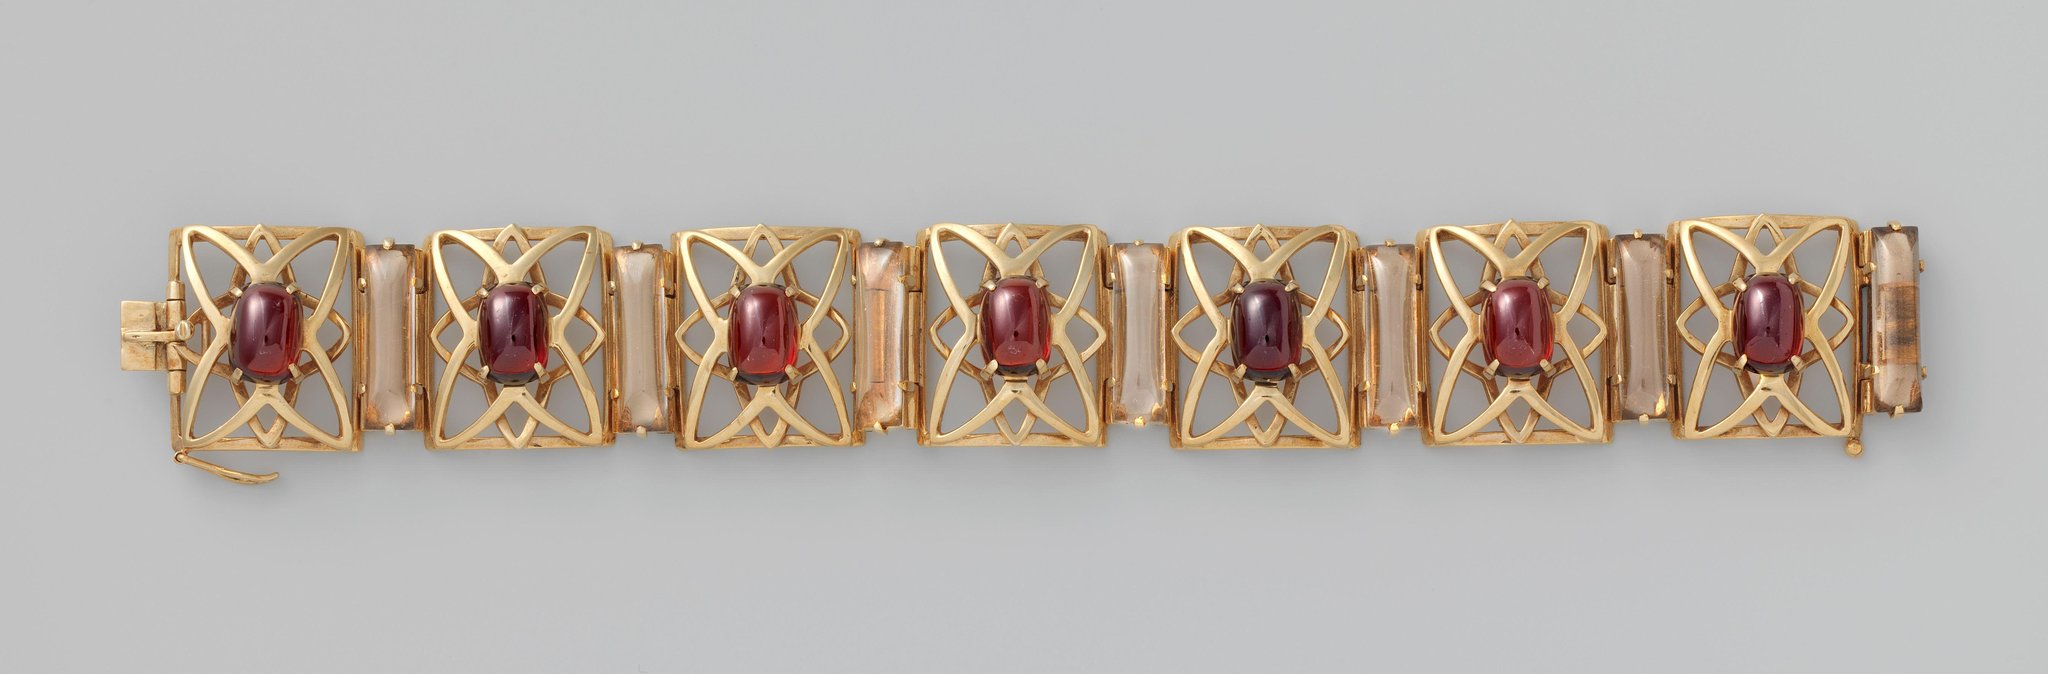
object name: bracelet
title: Armband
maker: gustav beran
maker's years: 1912-2006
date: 1953-1960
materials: gemstone, gold, mineral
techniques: grinding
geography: zeist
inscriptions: maker's mark: ‘VK in ovaal’, alloy mark: ‘eikenblad 585’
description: Armband van zeven identieke scharnierende gouden schakels. Elke schakel heeft een almandien en een maansteen. De armband is voorzien van een baksluiting met een veiligheidsacht. Erbij hoort één losse schakel.